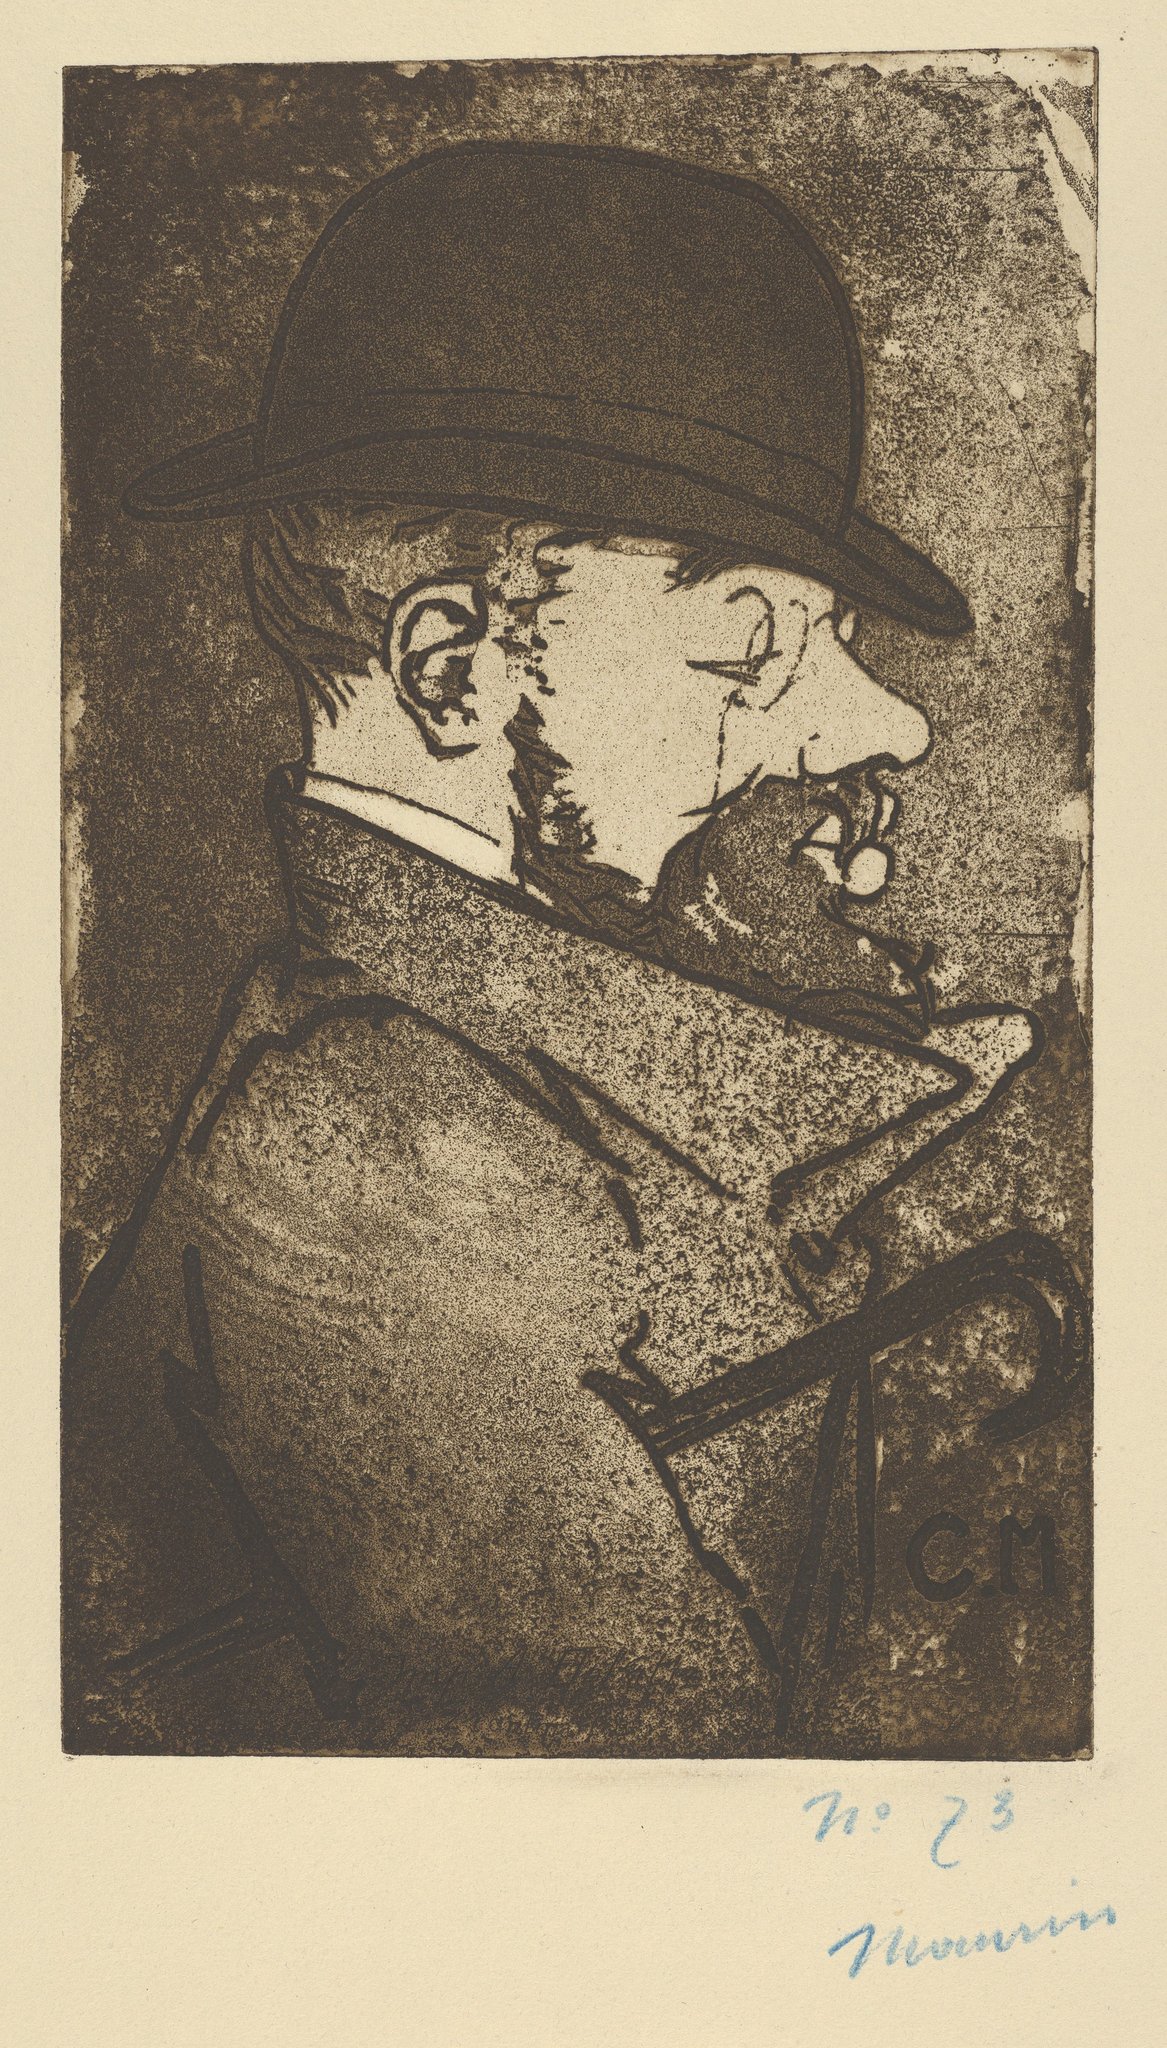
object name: print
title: Portrait of Toulouse-Lautrec (Portrait de Toulouse-Lautrec), from "L'Estampe Originale"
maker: charles maurin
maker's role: artist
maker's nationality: french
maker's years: 1856-1914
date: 1893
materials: ink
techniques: aquatint, printing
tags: men,profiles